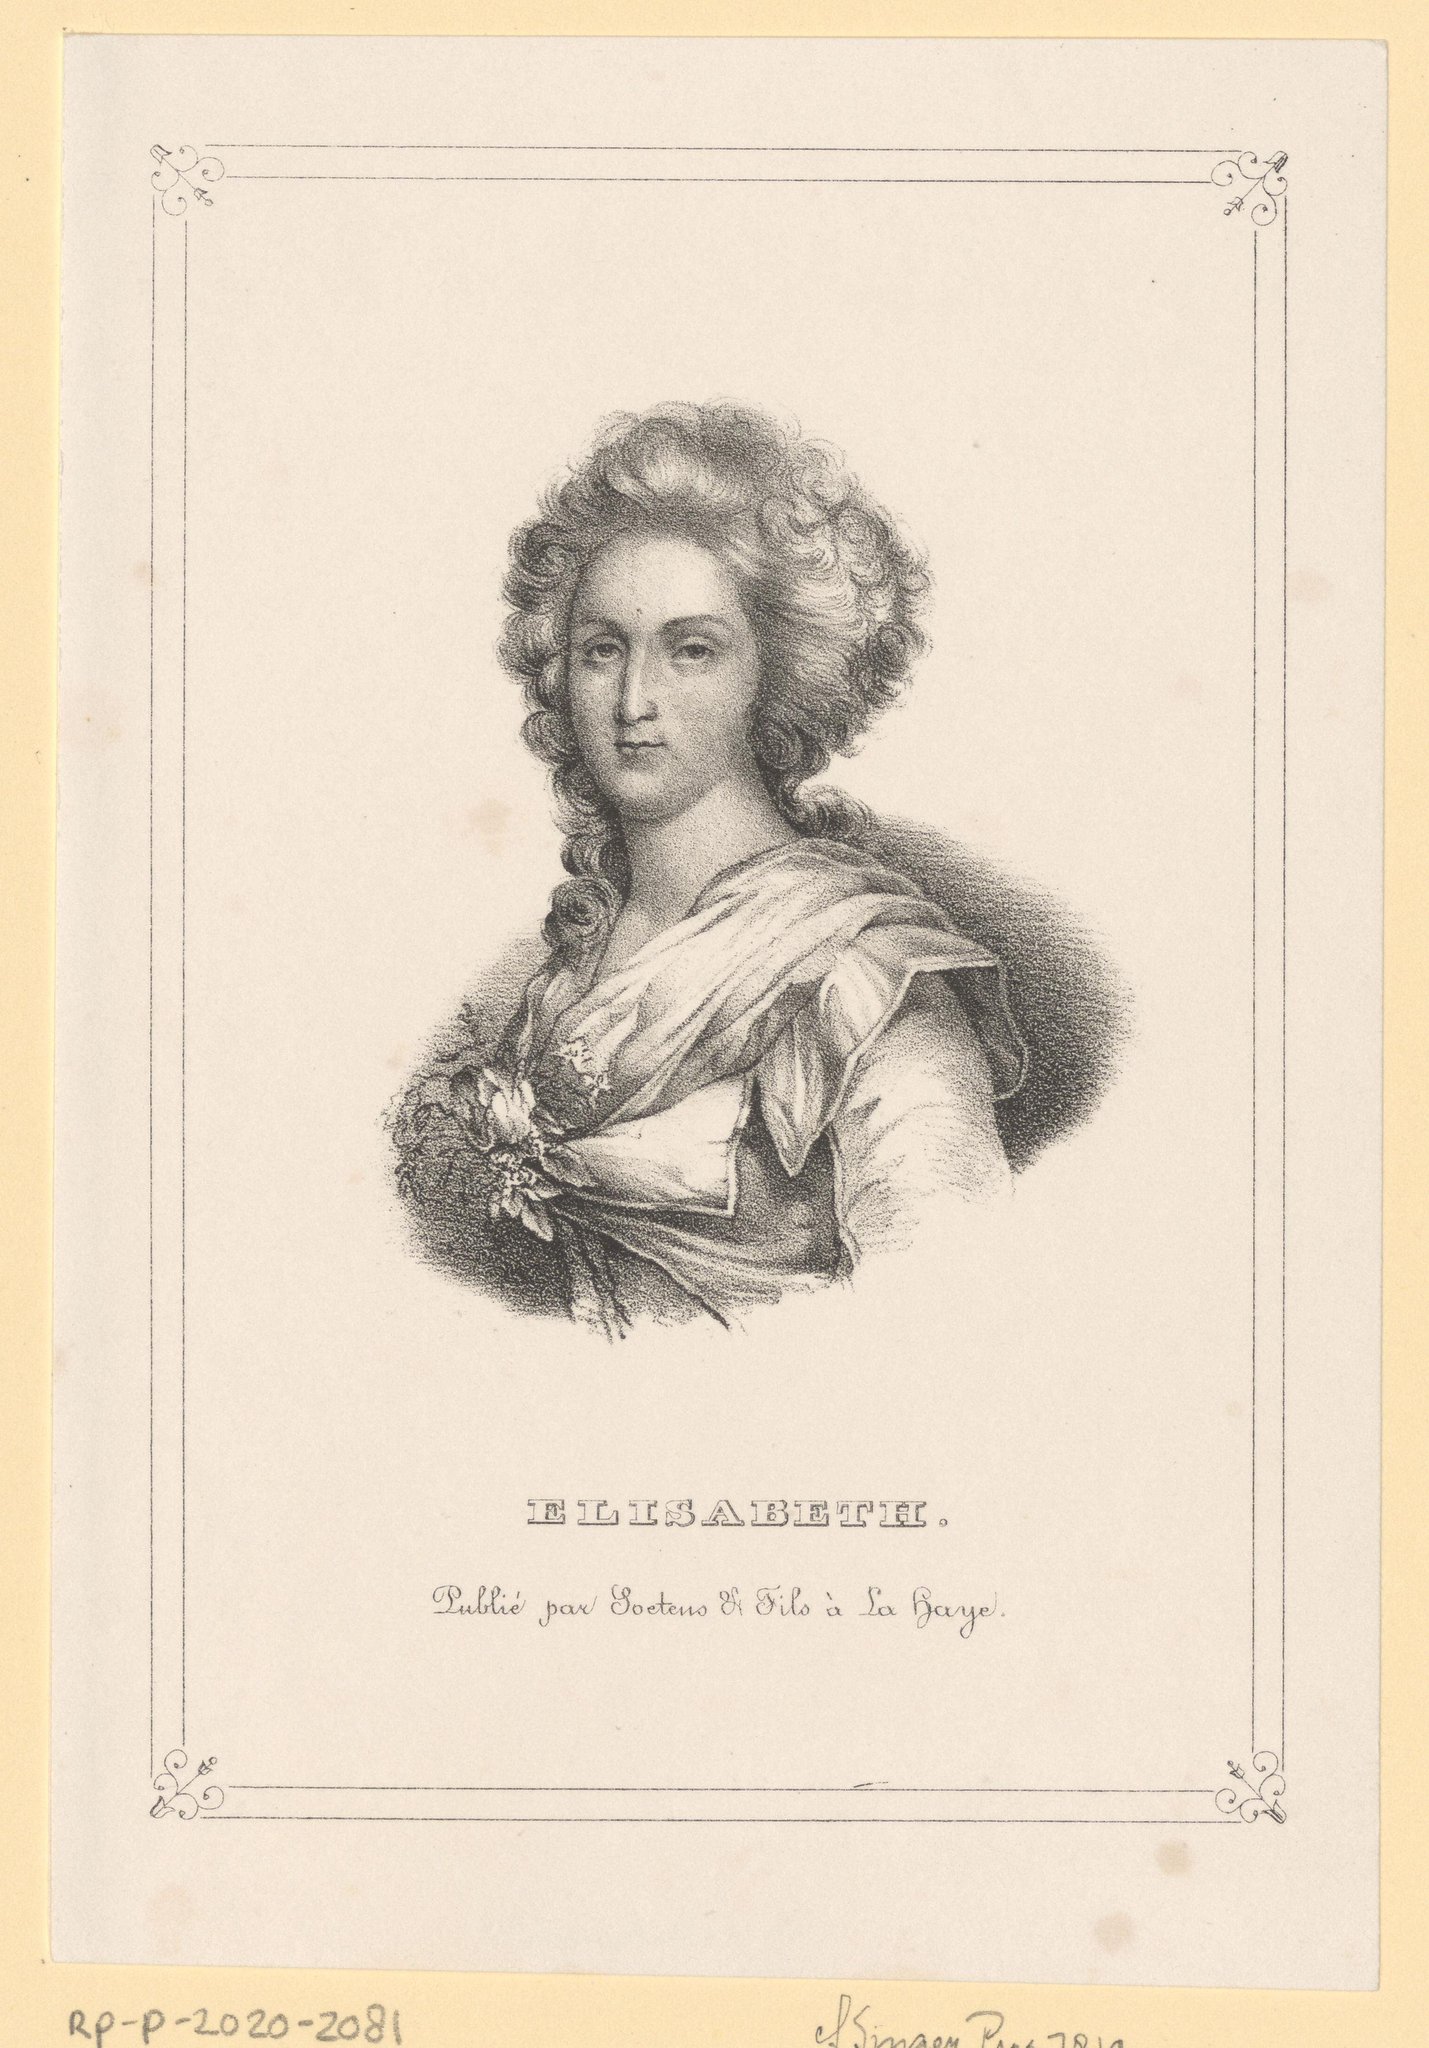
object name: print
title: Portret van Elisabeth van Frankrijk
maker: Anonymous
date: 1837-1840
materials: paper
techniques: lithograph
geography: the hague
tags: historical persons - bb - woman